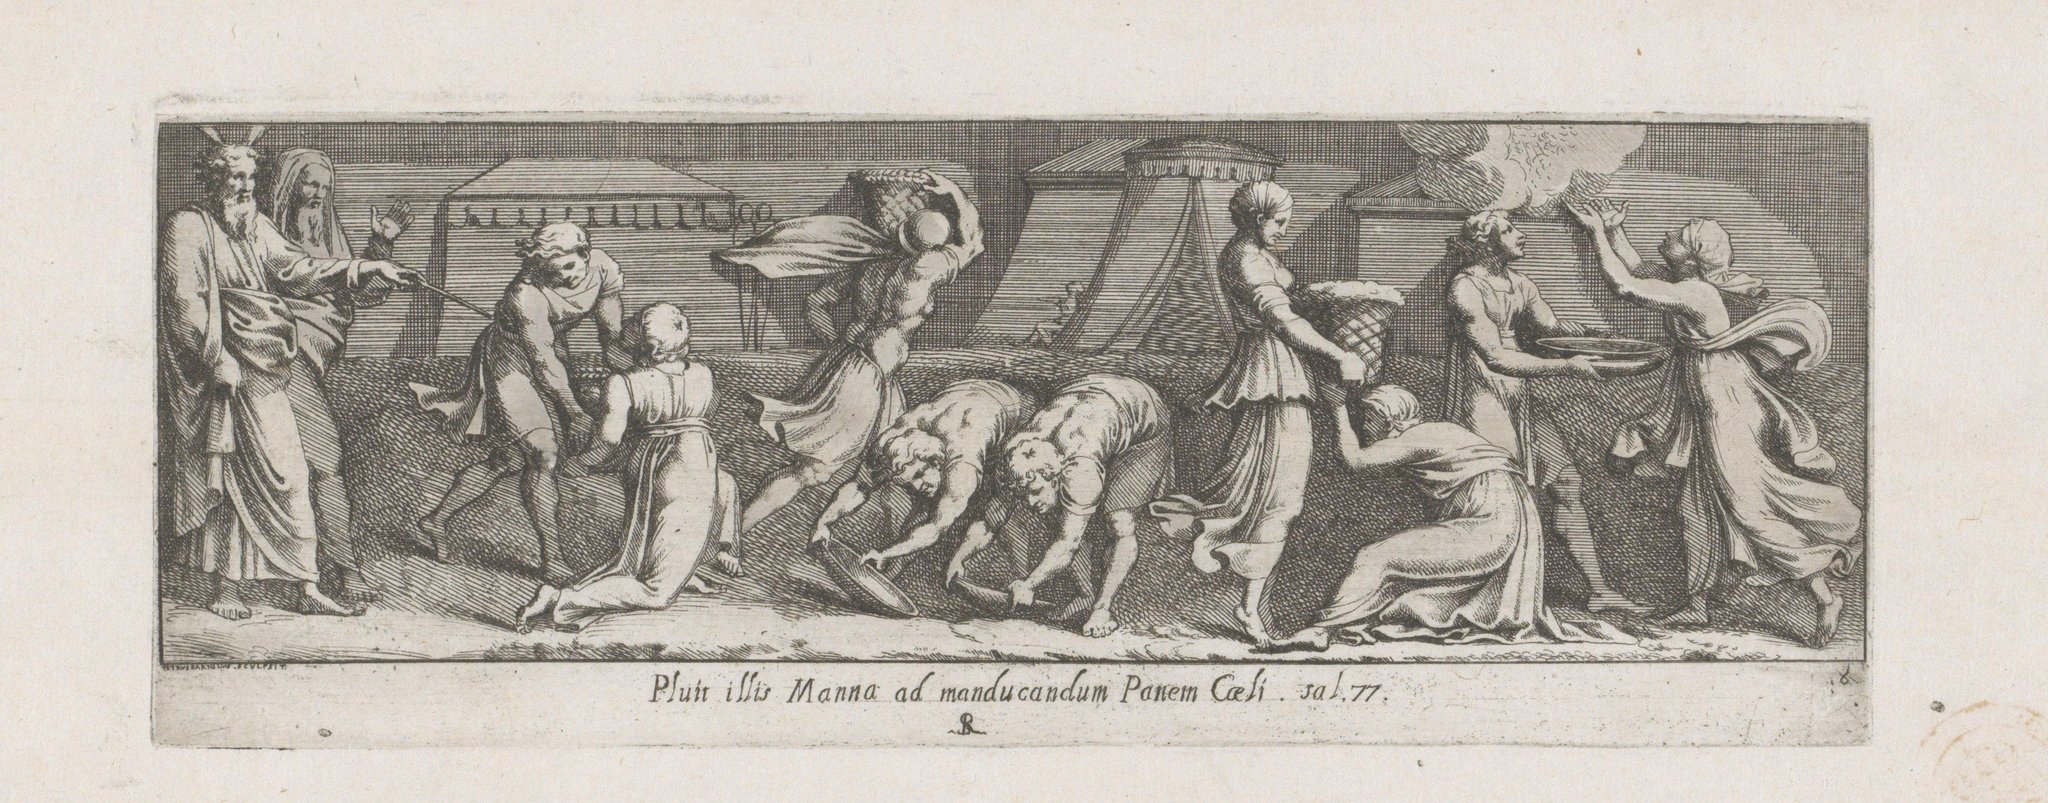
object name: print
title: Pluit illis Manna ad manducandum Panem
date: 1645-1700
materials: paper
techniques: engraving, etching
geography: vatican city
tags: the gathering of manna (in baskets and pots), in the morning manna falls to the earth ~ exodus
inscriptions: collector's mark: Lugt 240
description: Prent naar verloren gegane schilderingen (basamenti) in de Vaticaanse Loggia naar ontwerp van Rafaël, mogelijk door Perino del Vaga geschilderd.